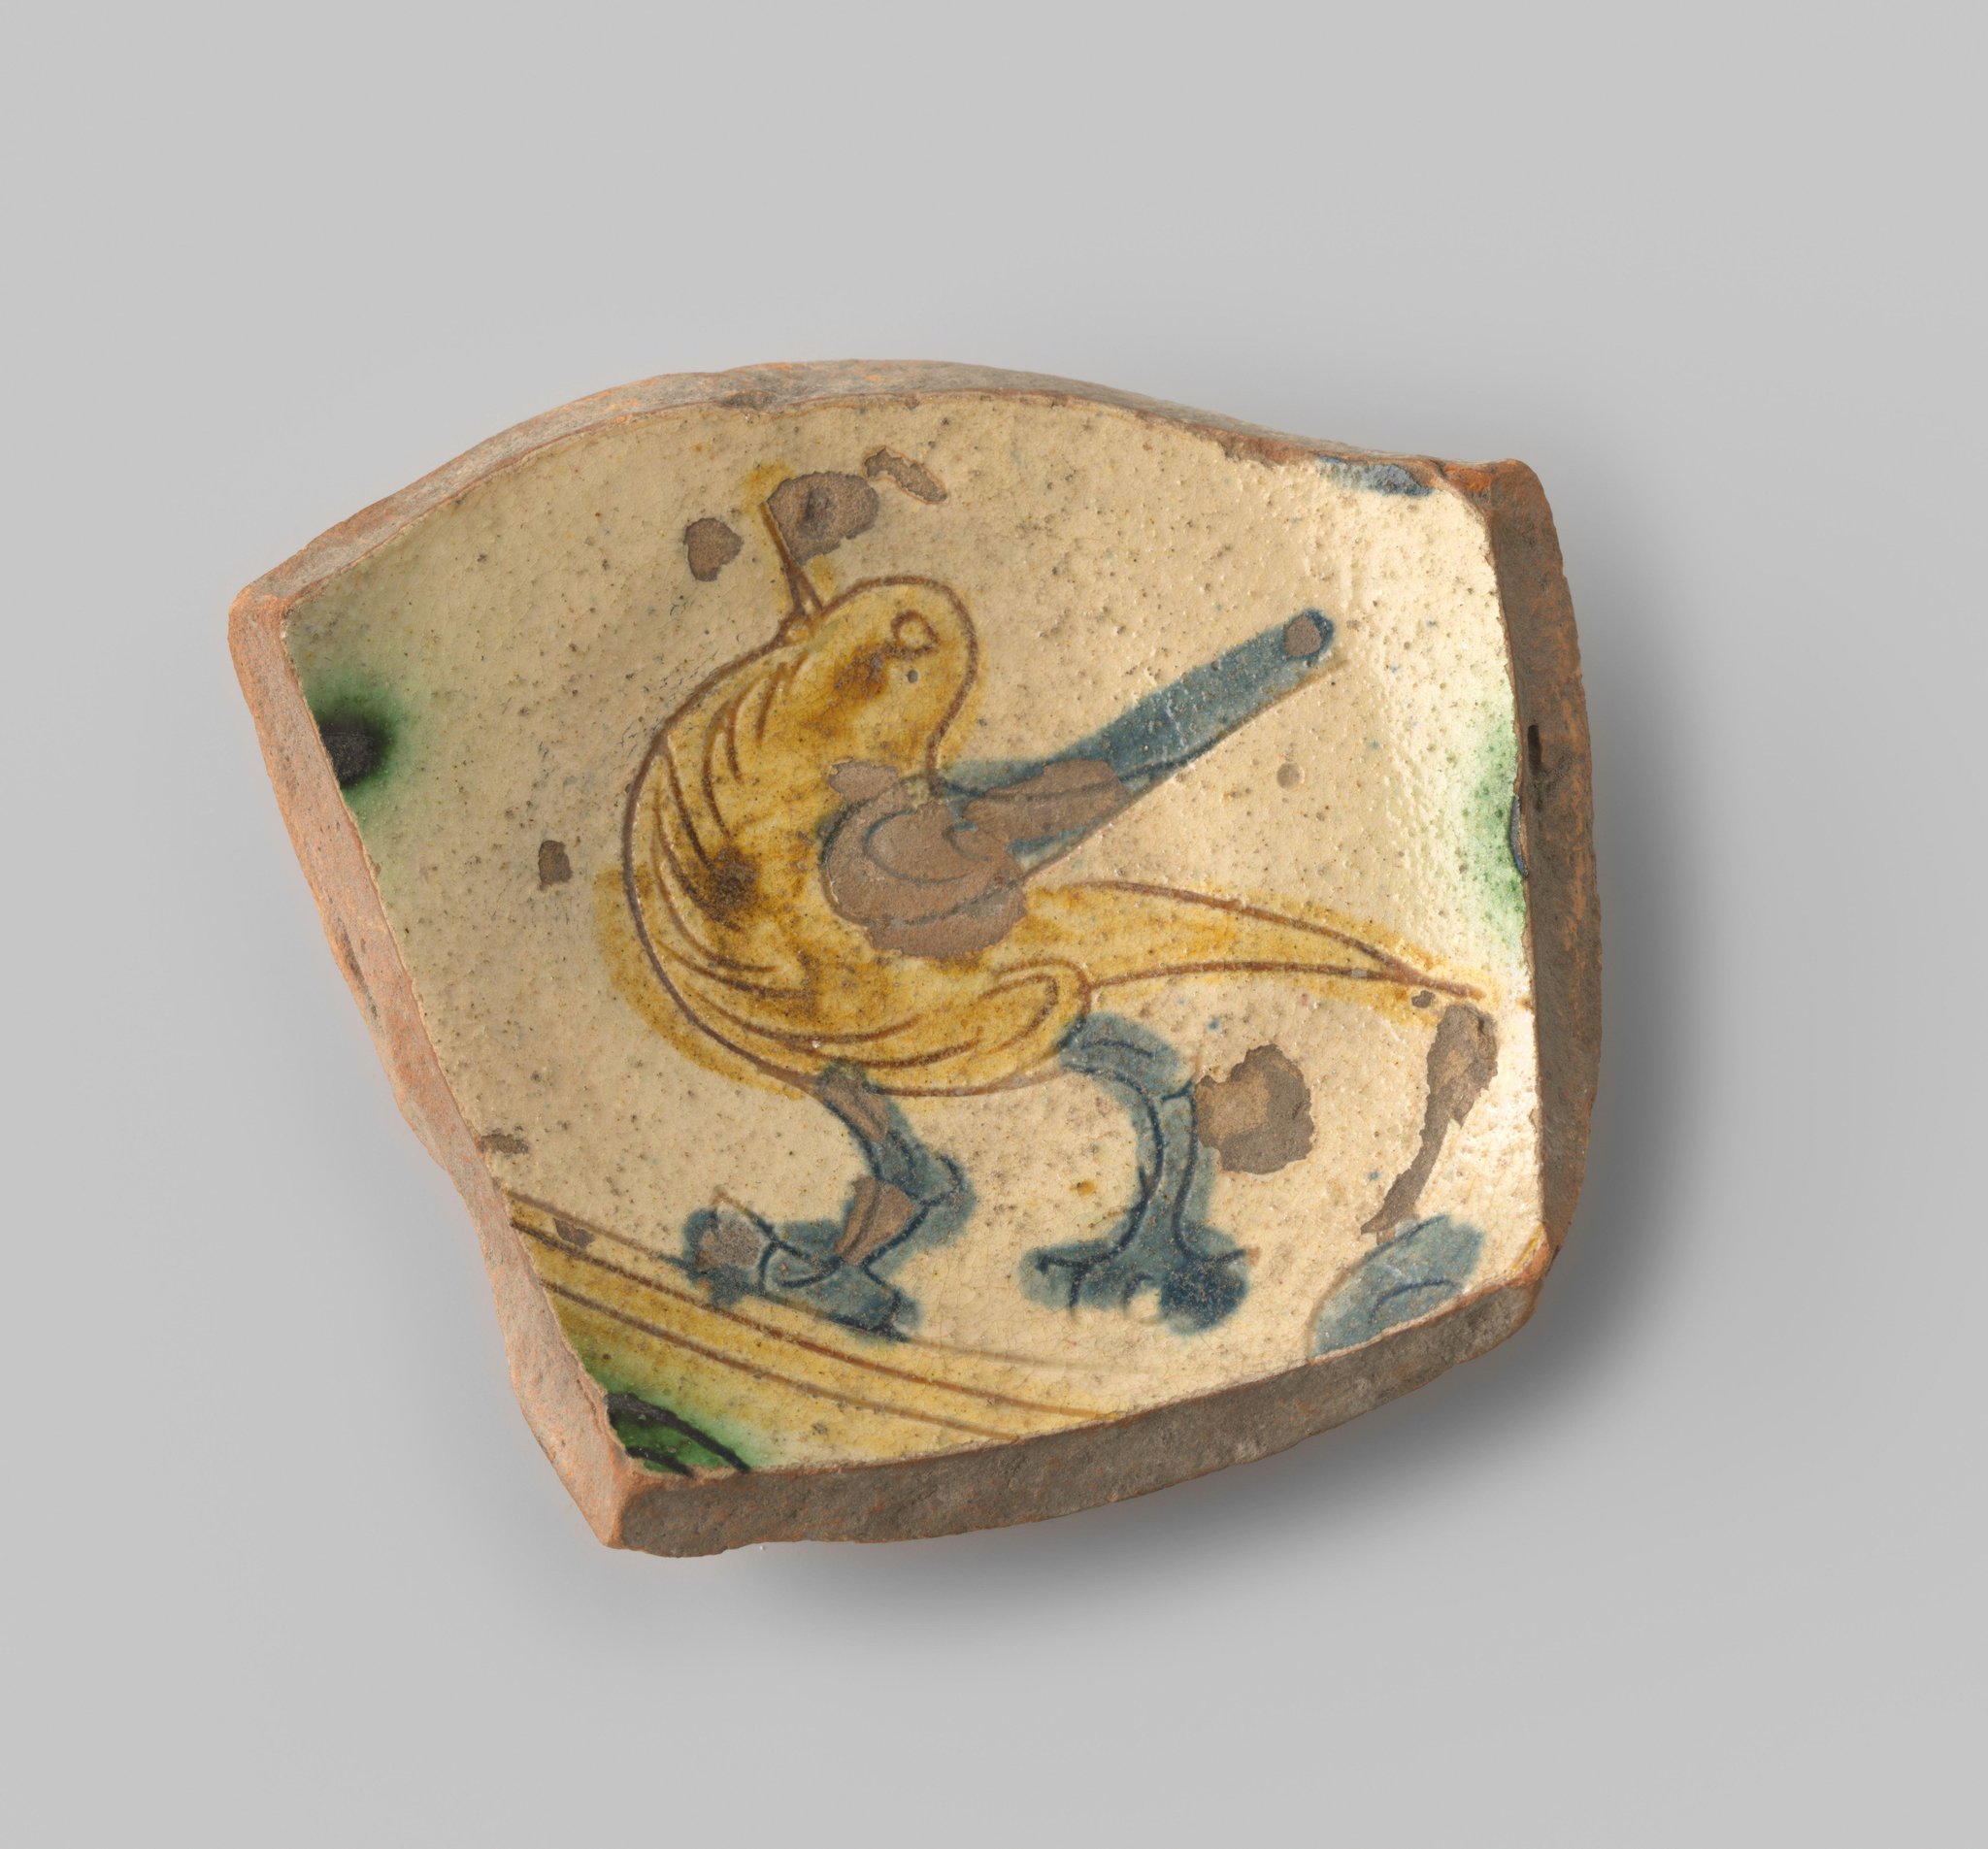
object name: sherd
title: Fragment (voet) met rode scherf, aan de binnenkant in sgraffito-techniek een vogel in oker en blauw op een tak, op een beige fond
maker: Anonymous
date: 1200-1899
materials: earthenware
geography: italy